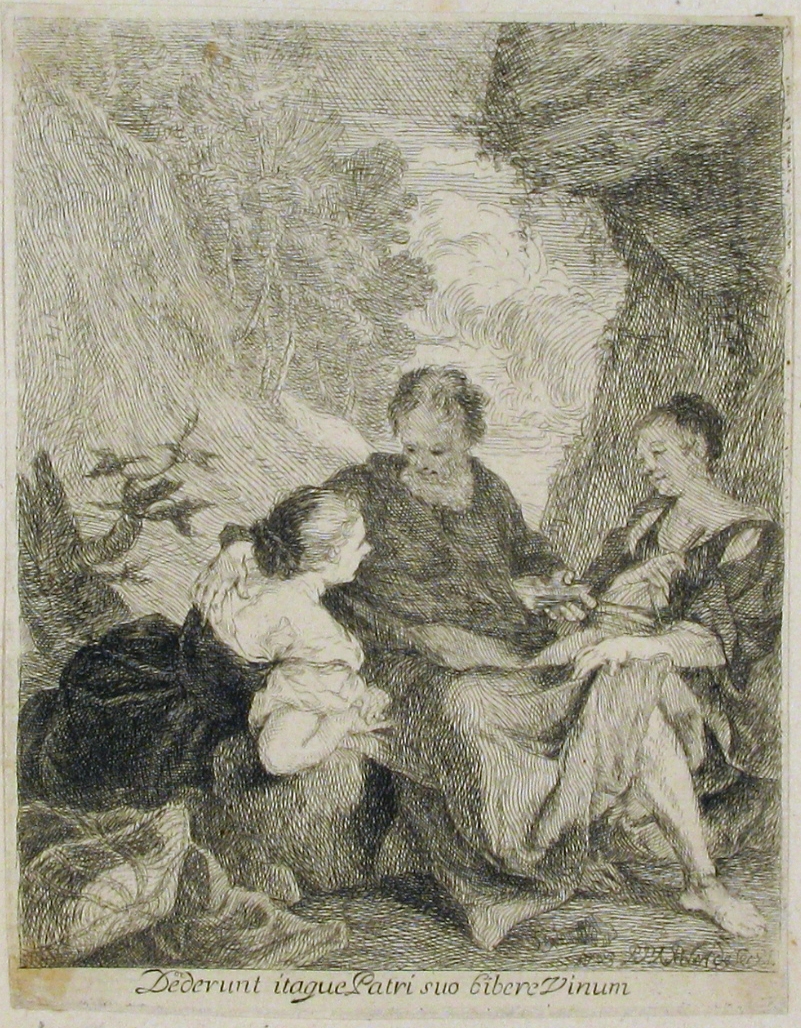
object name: print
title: Lot and His Daughters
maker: paul ponce antoine robert-de-seri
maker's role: artist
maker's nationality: french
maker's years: 1686-1733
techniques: etching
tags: men,women